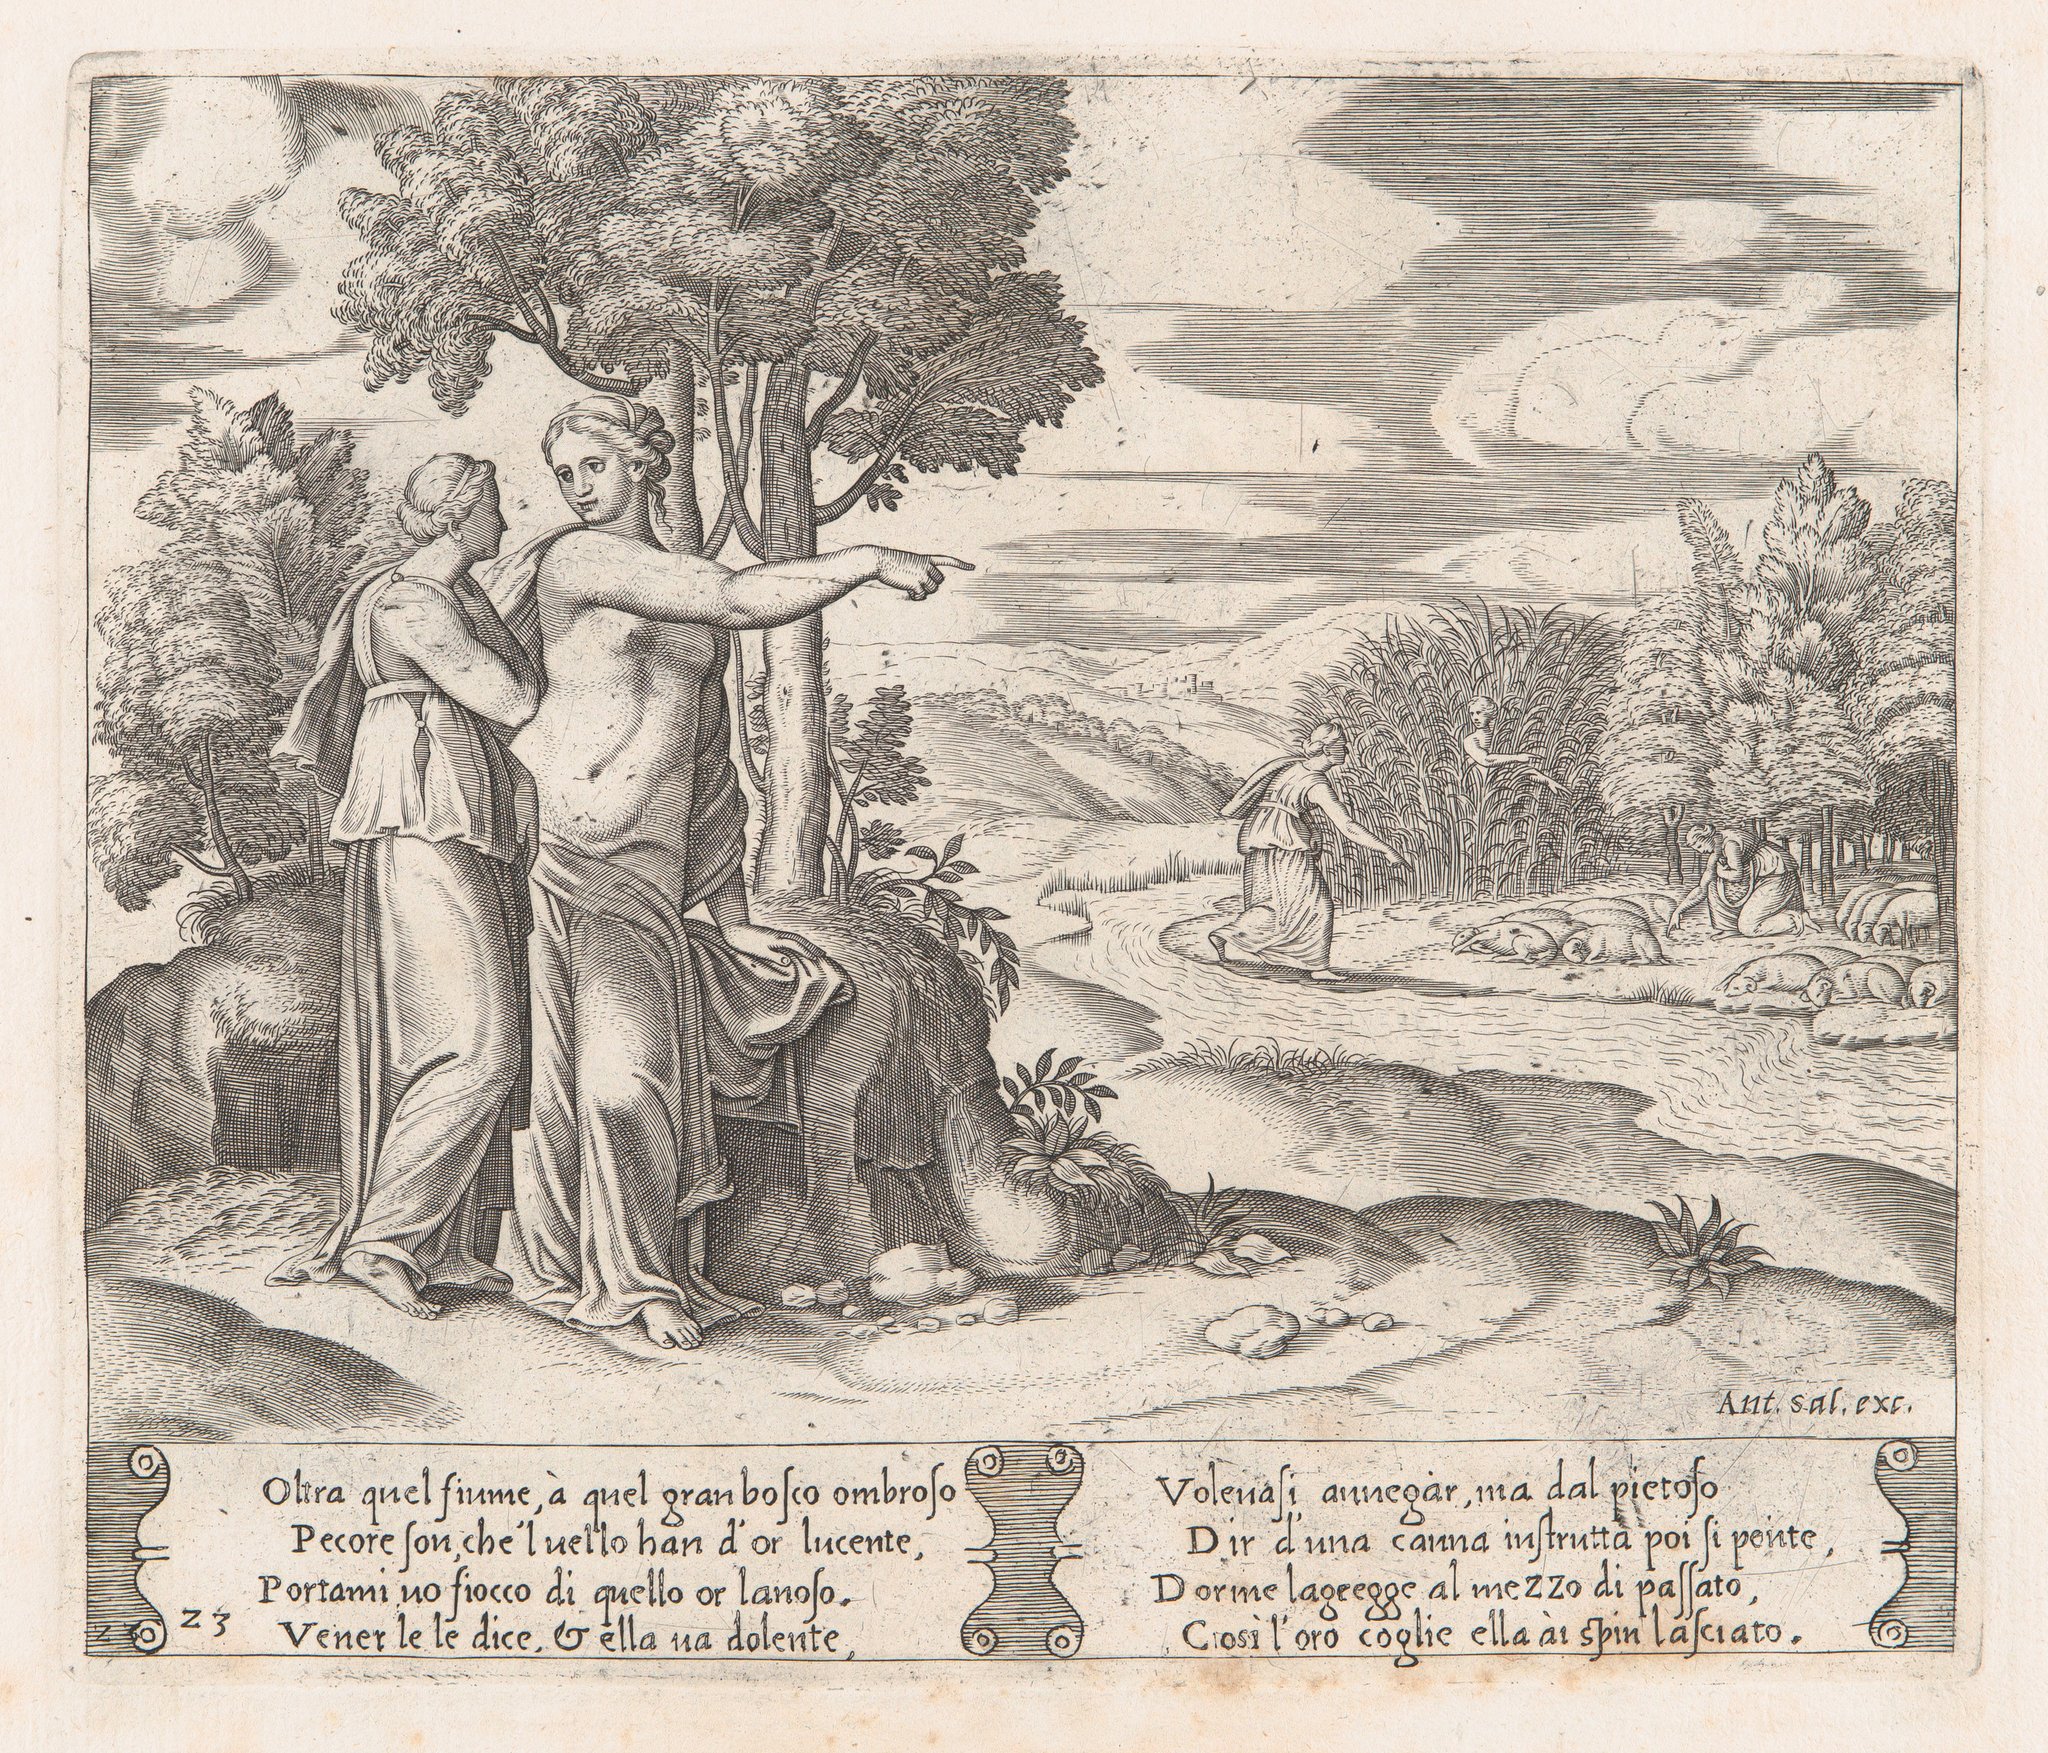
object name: print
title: Plate 23: Psyche on the order of Venus departing to find the golden fleece, from "The Story of Cupid and Psyche as told by Apuleius"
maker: master of the die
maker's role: artist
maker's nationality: italian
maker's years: 1525-1560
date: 1530-1560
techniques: engraving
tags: psyche,venus,trees